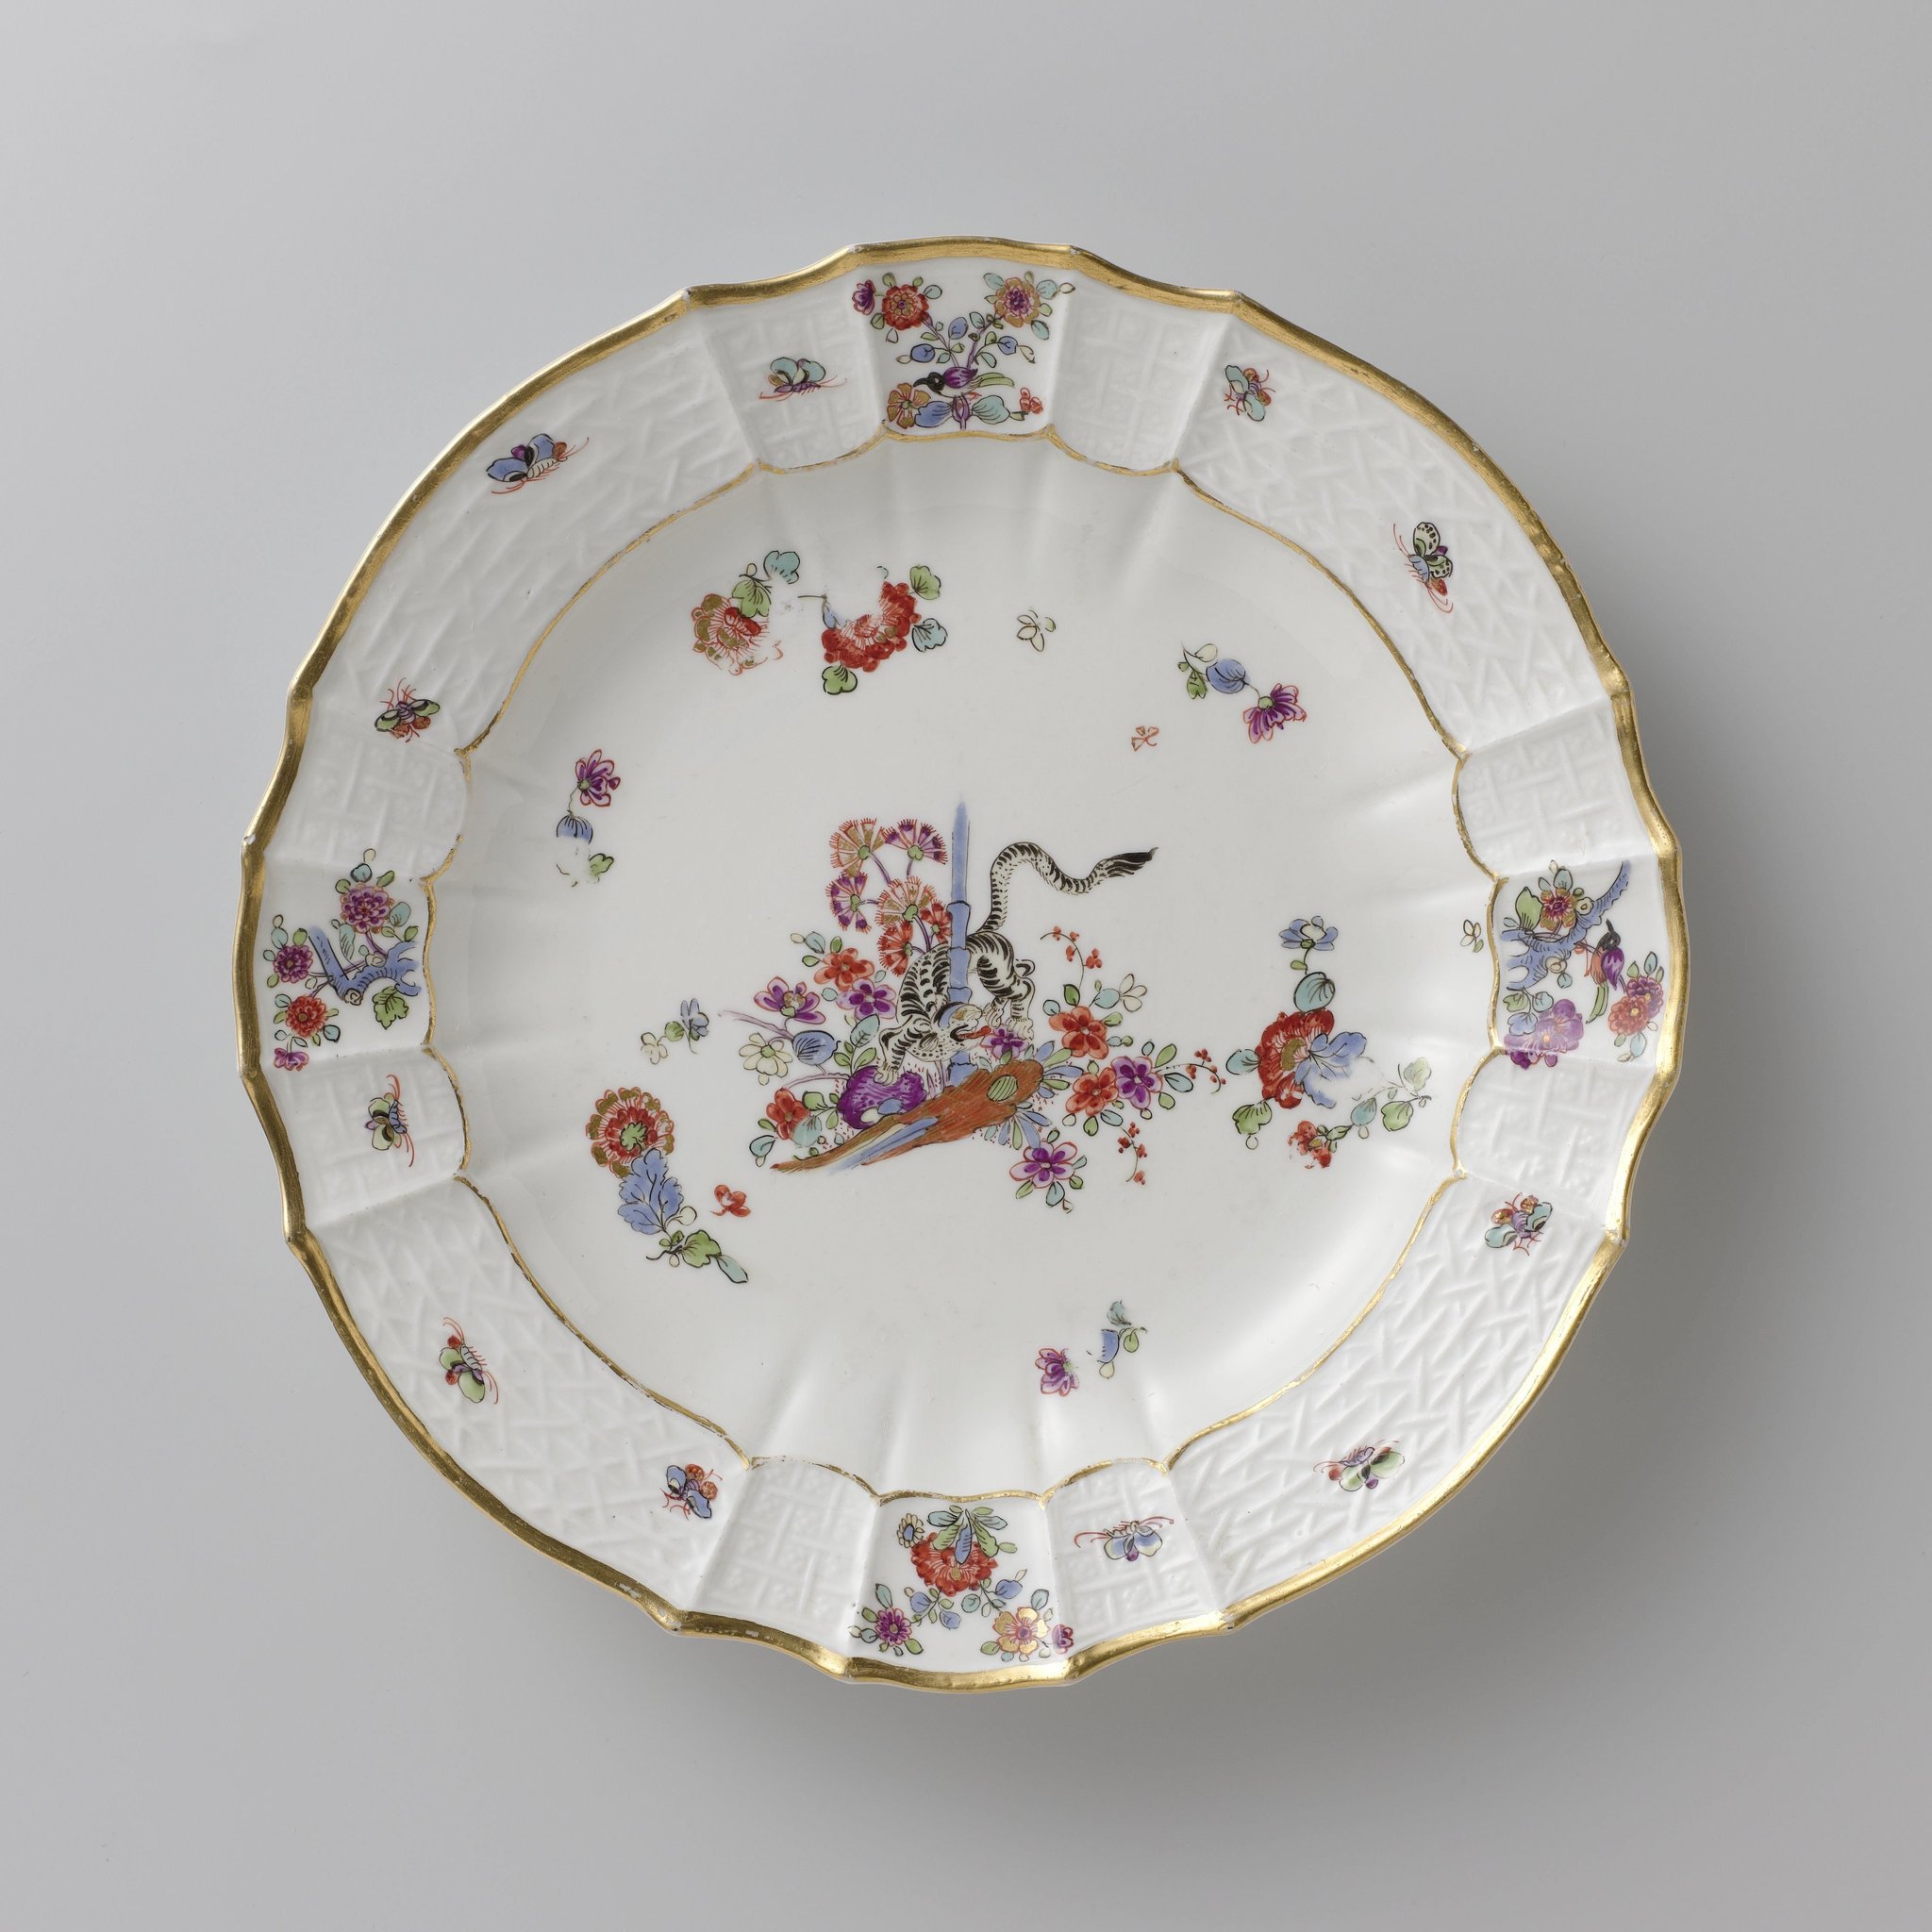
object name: plate dish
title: Rond bord, veelkleurig beschilderd met een Kakiemon-decor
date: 1740-1745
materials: porcelain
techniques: painted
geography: meissen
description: Rond bord van beschilderd porselein. Het bord is geribd en heeft een geschulpte rand. Het bord is beschilderd met een tijger die om een blauwe bamboestengel tussen bloemen is gedraaid, gestrooide Indianische Blumen, vlinders en takken waarop vogels. De rand is versierd met het 'Altbrandenstein'-patroon. Het bord is gemerkt.